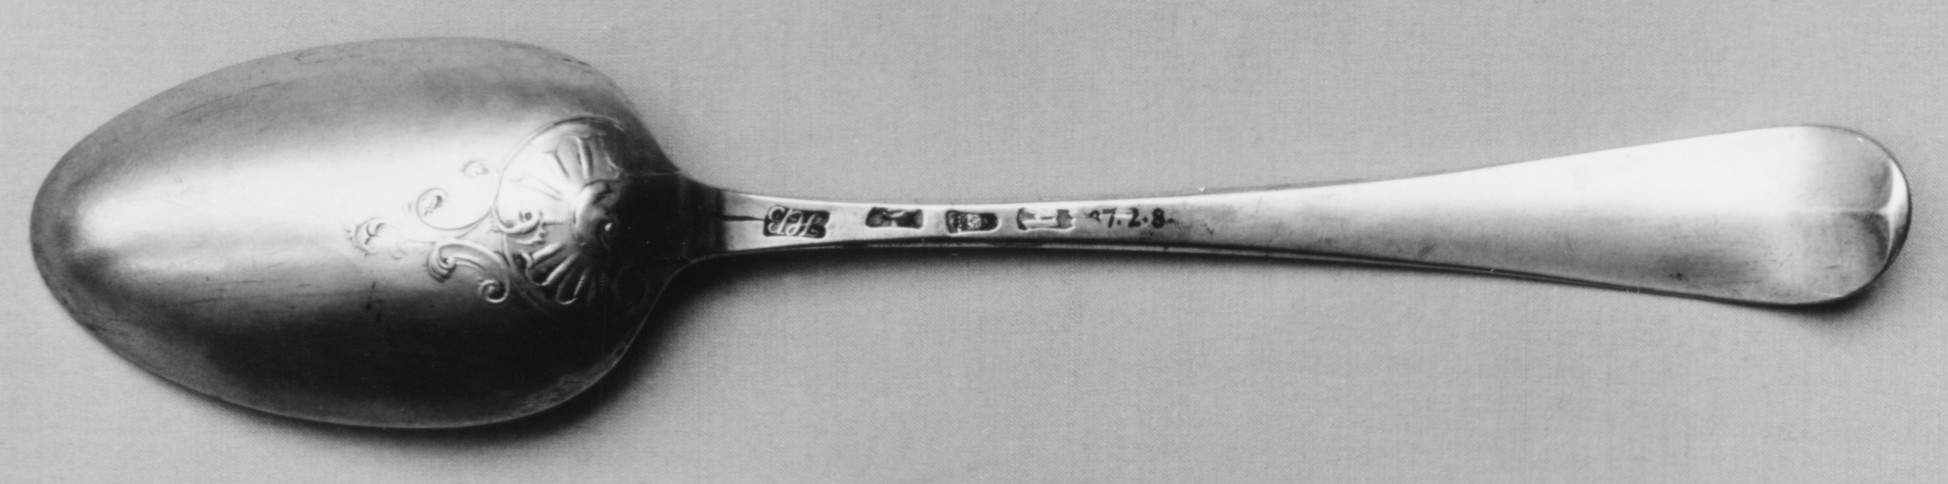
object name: tablespoon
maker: hester bateman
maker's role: maker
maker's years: 1761-1790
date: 1777-1778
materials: silver